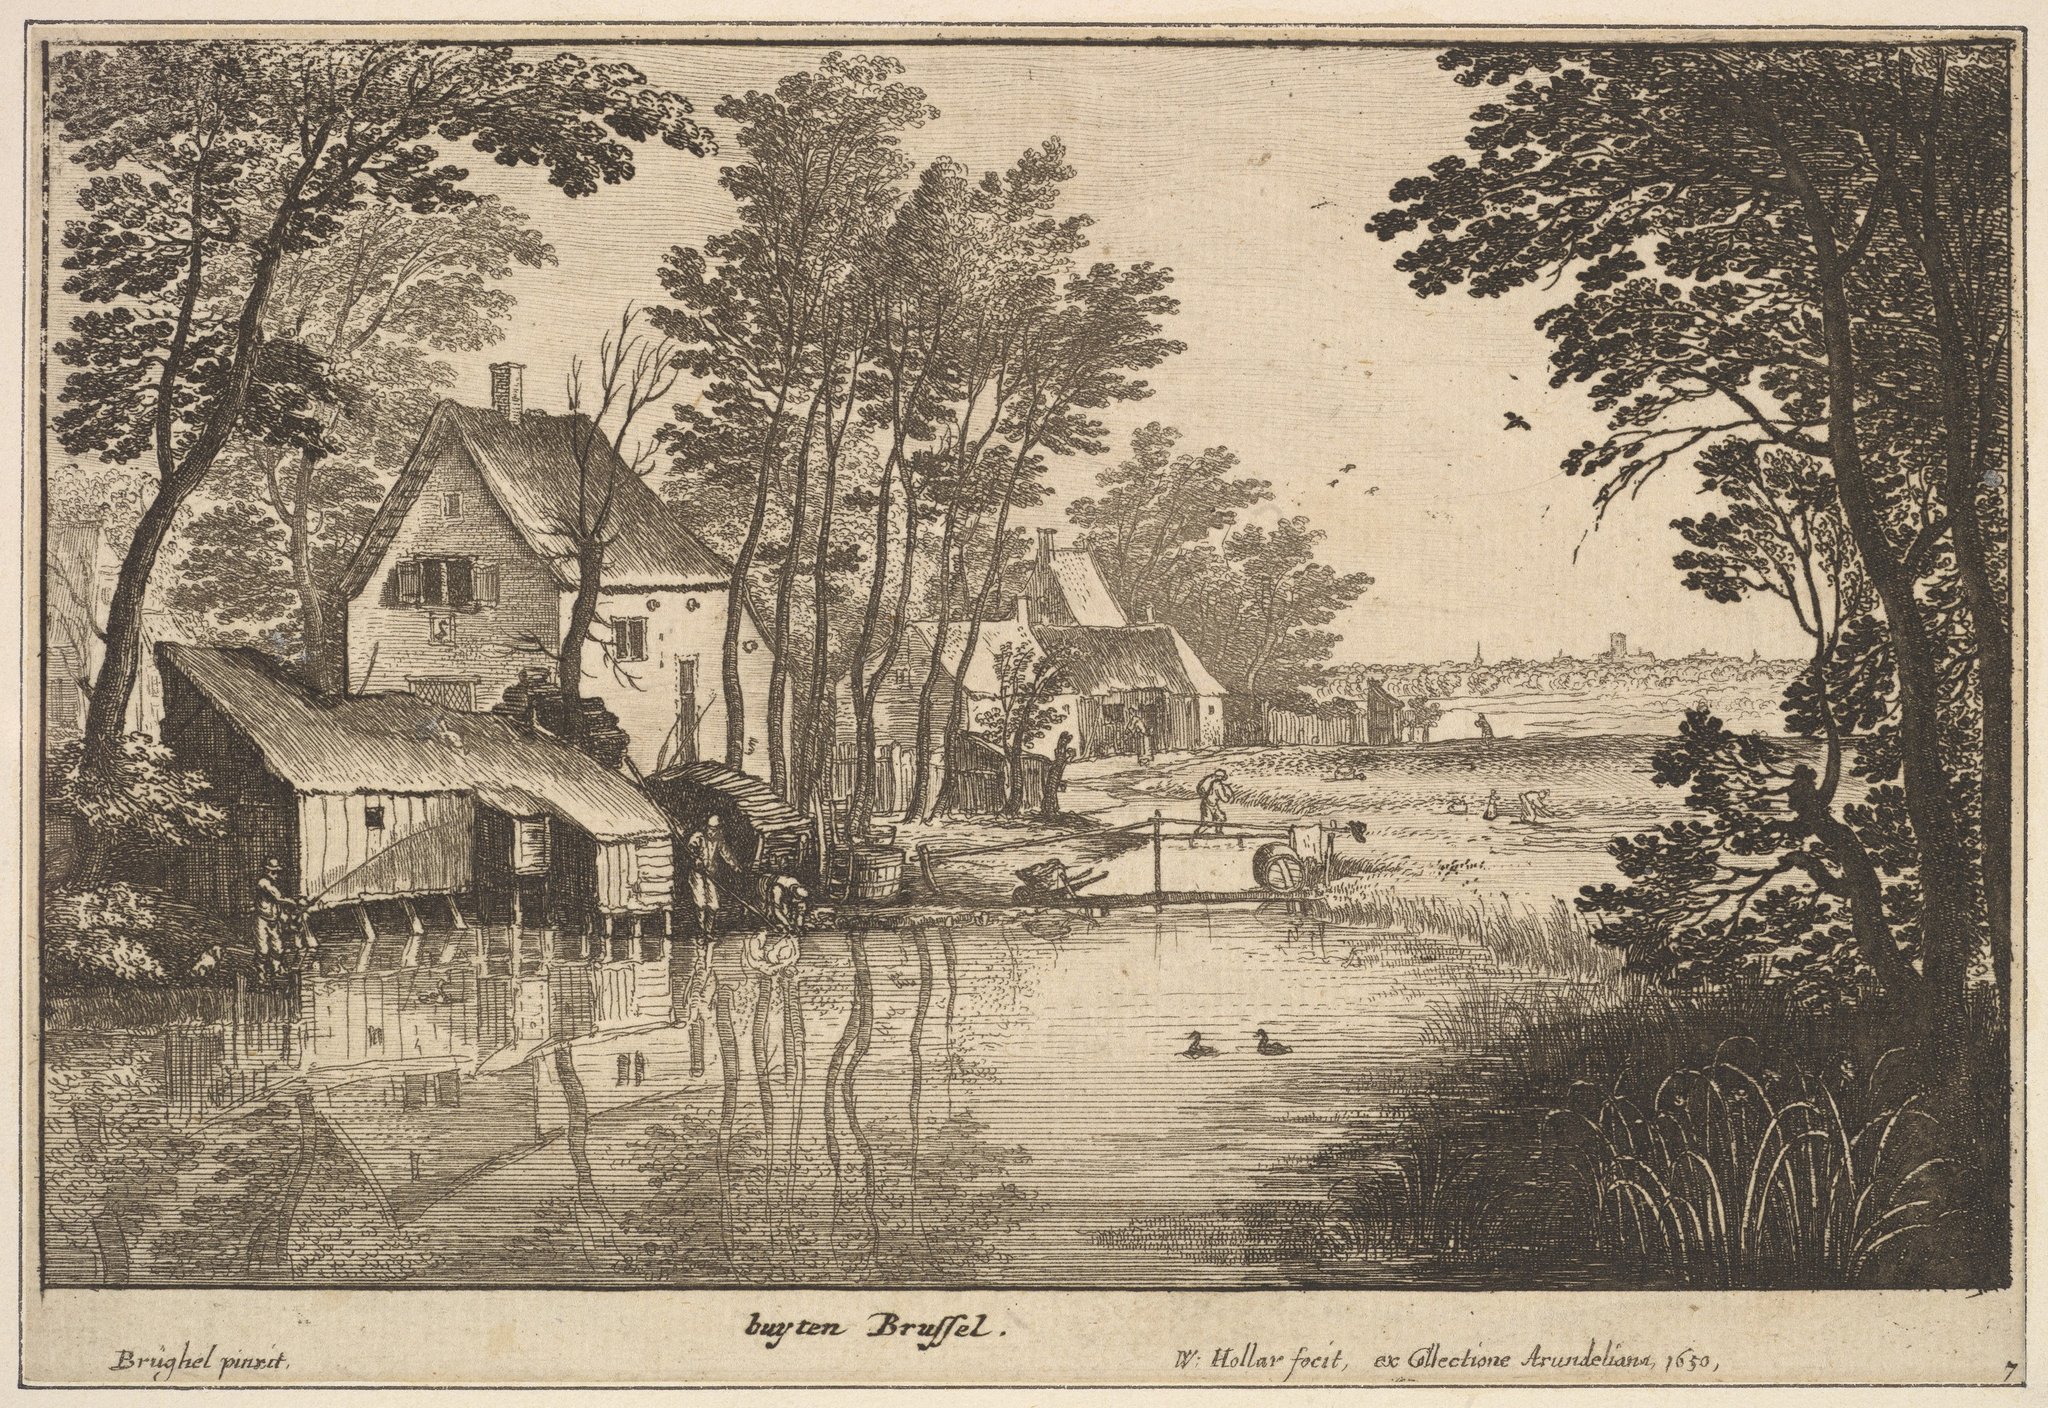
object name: print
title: Landscape with an Angler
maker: wenceslaus hollar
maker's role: artist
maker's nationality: bohemian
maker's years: 1607-1677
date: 1650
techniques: etching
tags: houses,fishing,landscapes